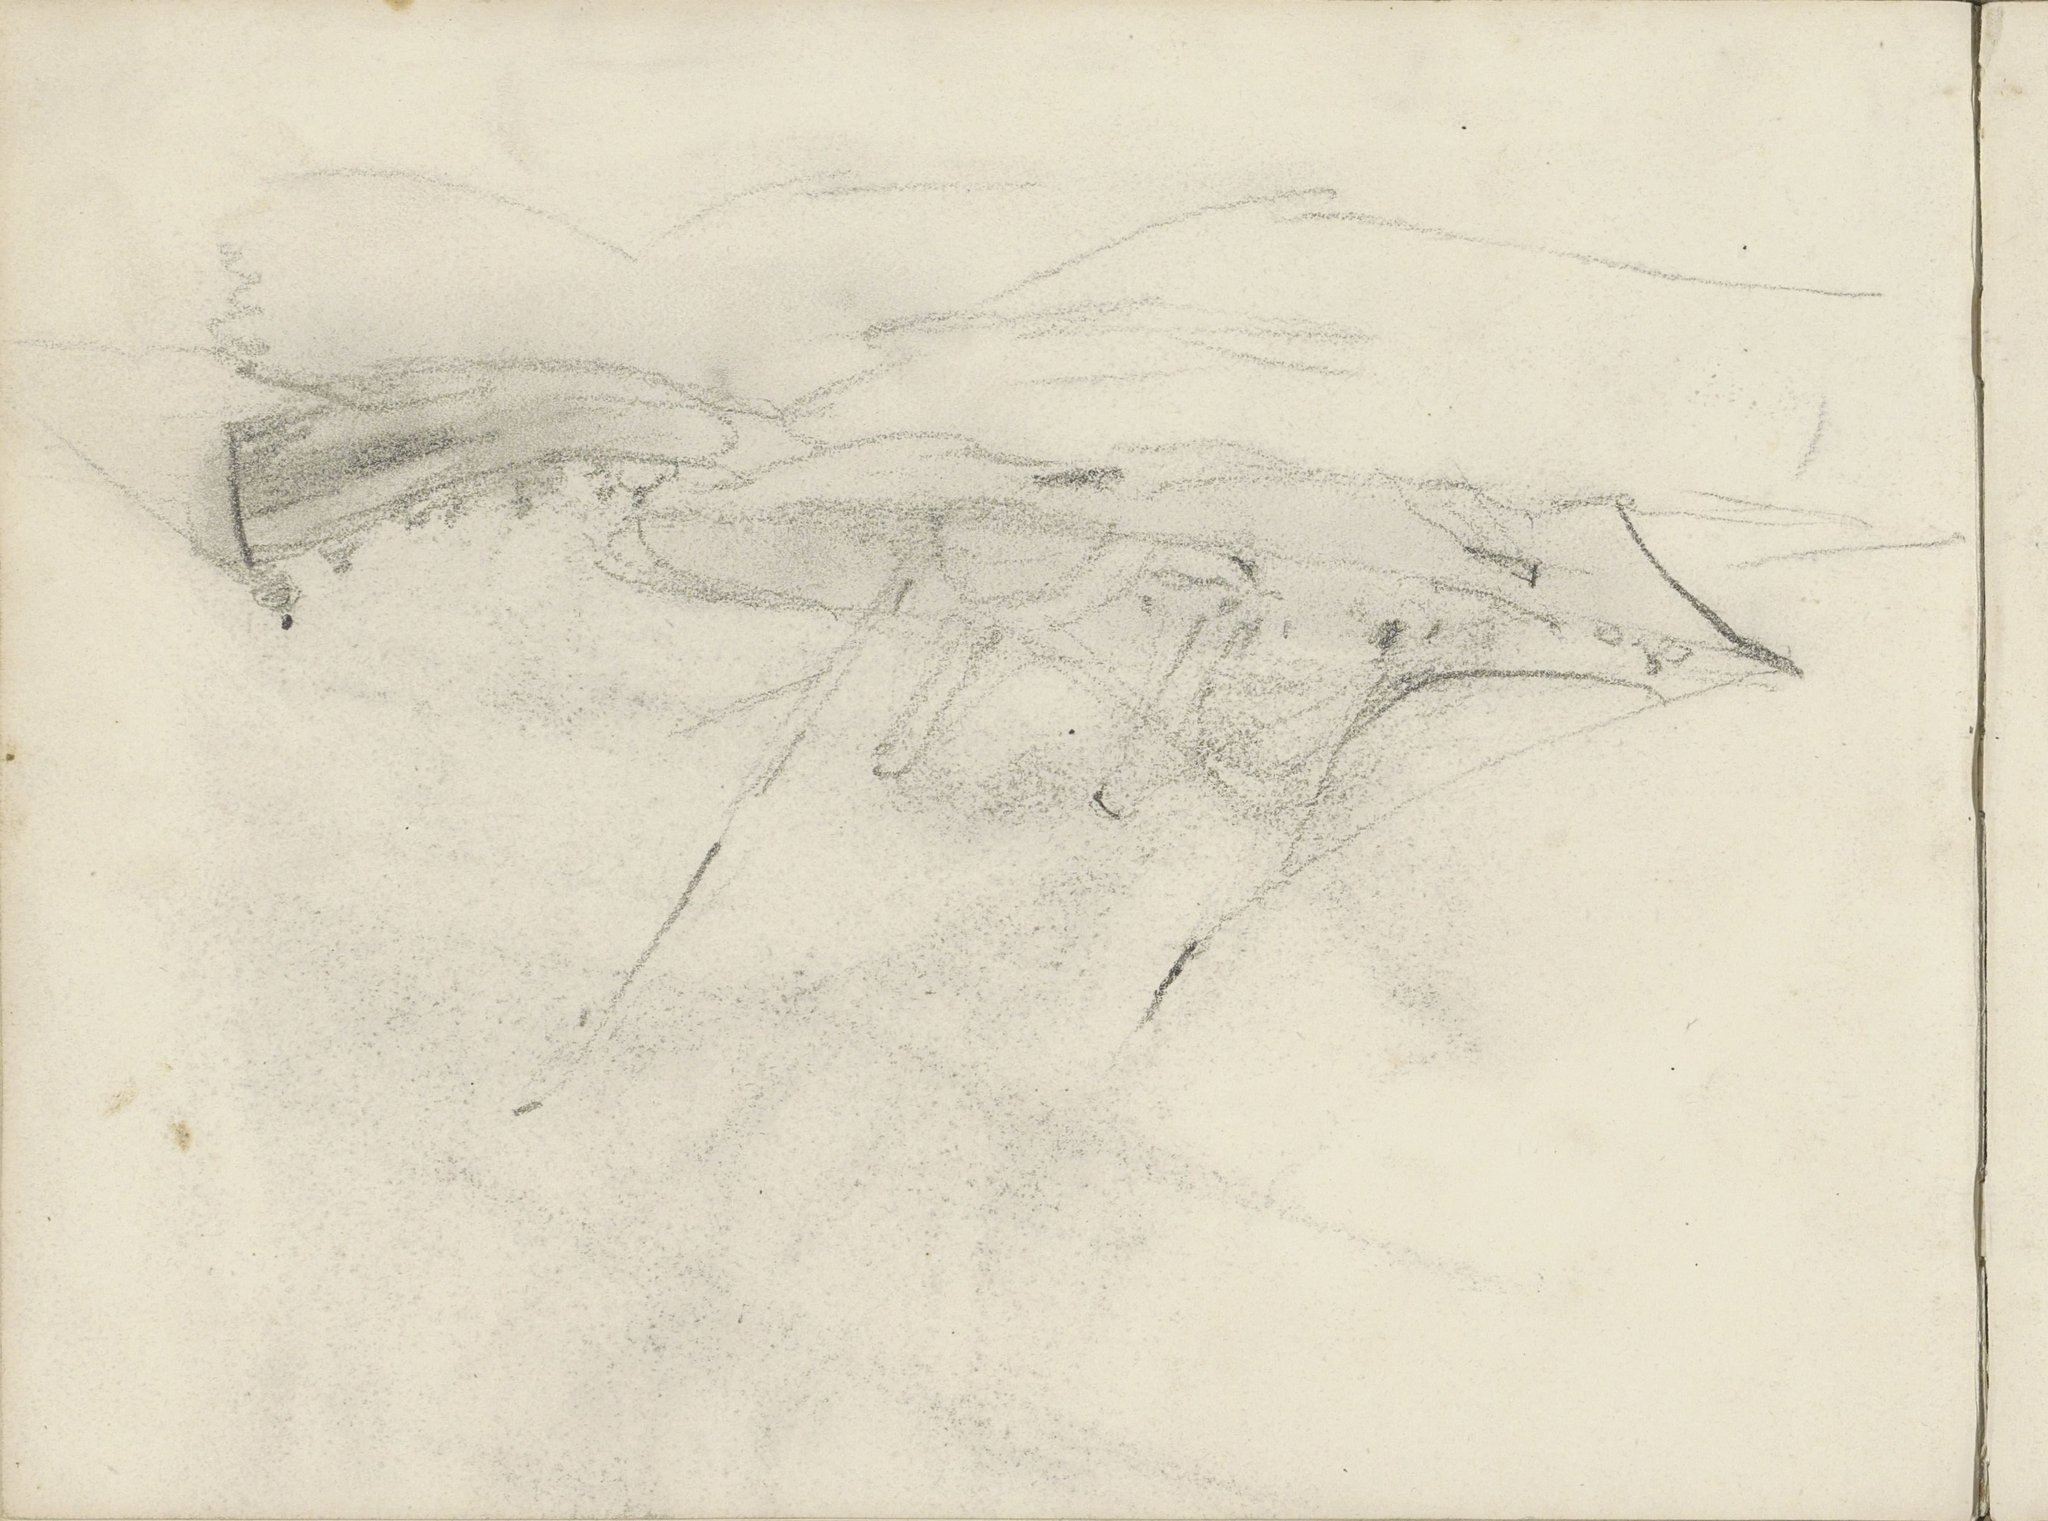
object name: sketchbook leaf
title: Zeilschip en sloep op een stormachtige zee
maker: petrus johannes schotel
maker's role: draughtsman, painter, print maker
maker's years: 1808-1865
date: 1825-1875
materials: paper, pencil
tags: storm at sea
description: Blad 41 verso uit een schetsboek met 44 bladen.